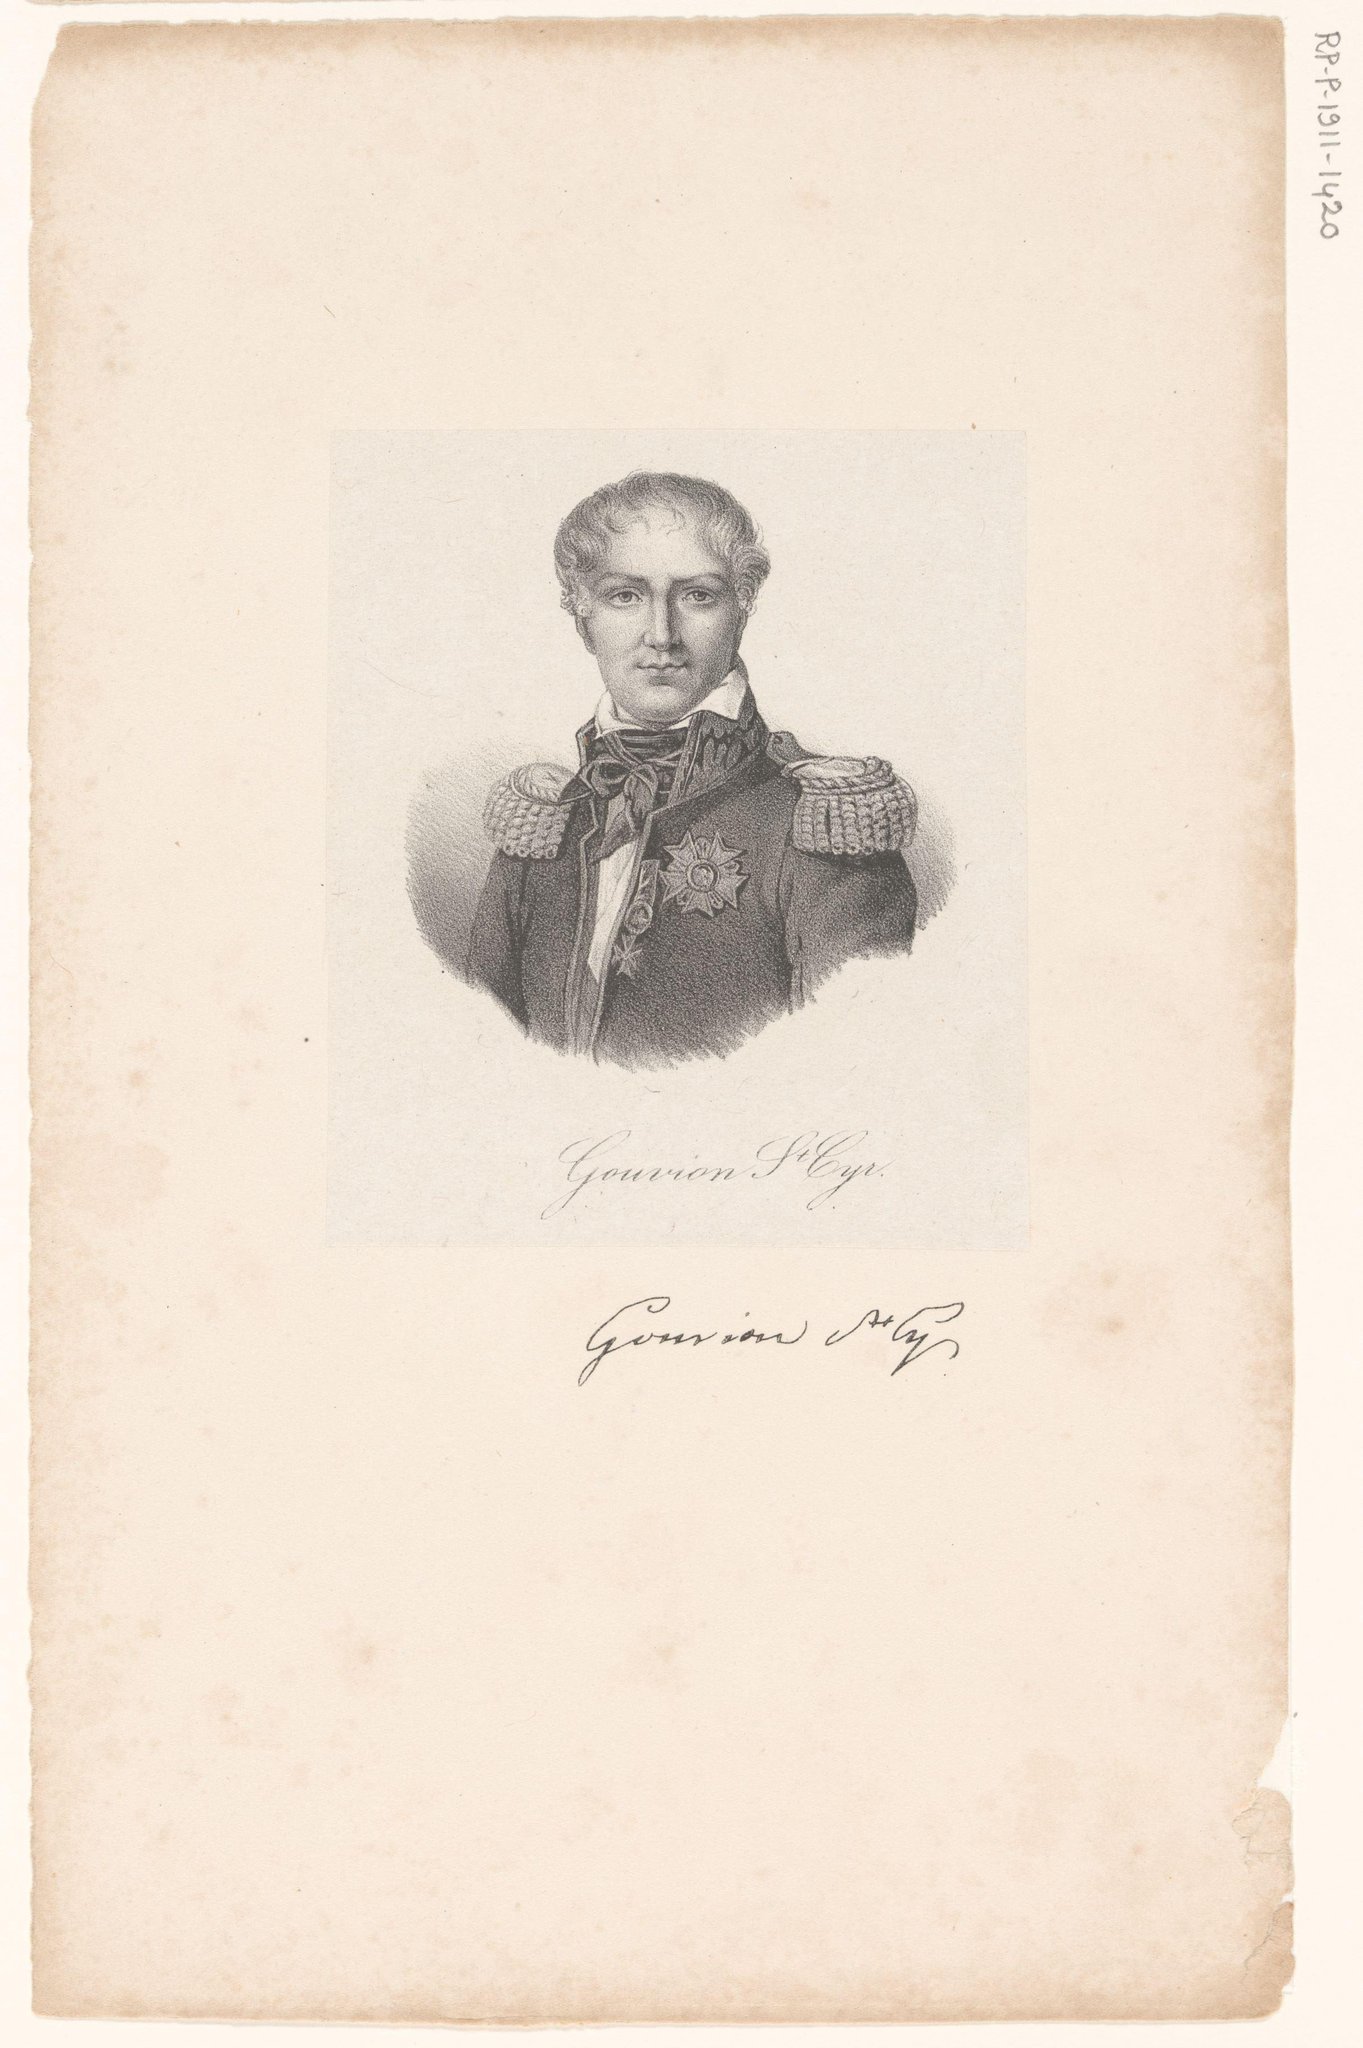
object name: print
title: Portret van Laurent de Gouvion-Saint-Cyr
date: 1818-1842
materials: paper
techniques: lithograph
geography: paris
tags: historical persons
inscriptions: collector's mark: Lugt 2228a